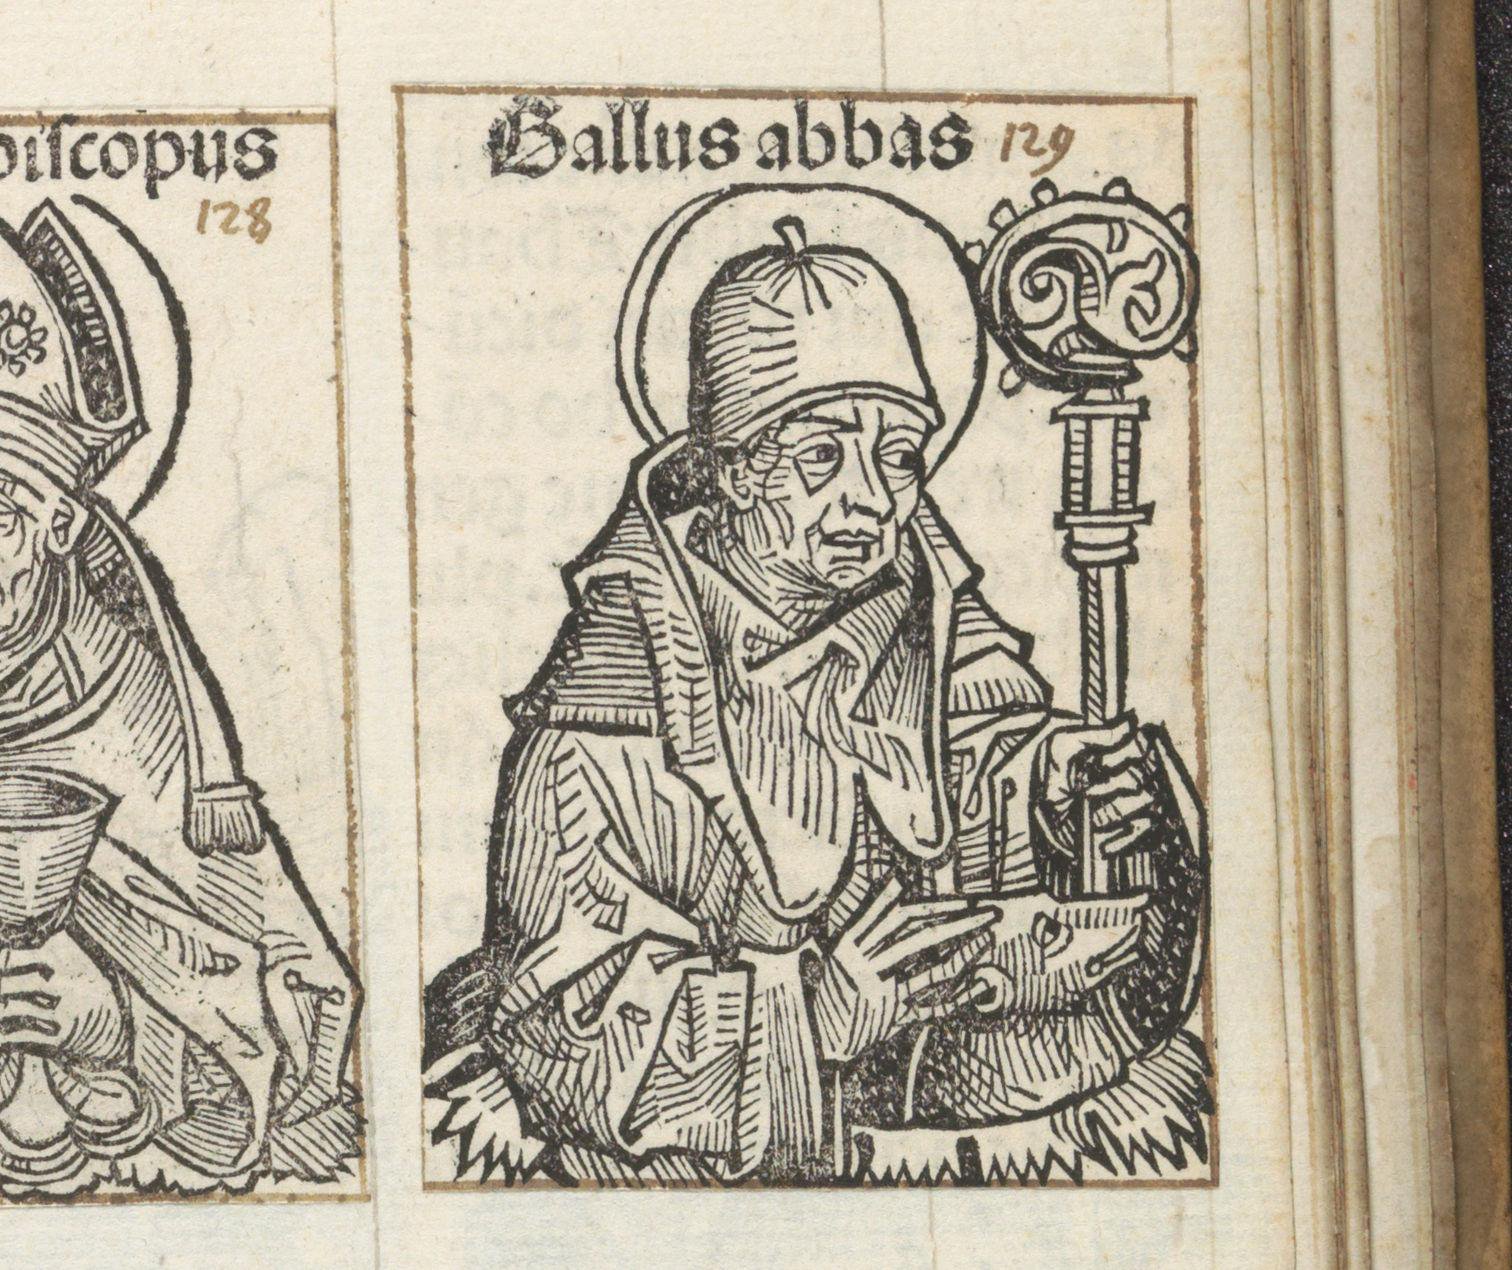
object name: album leaf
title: Liber Chronicarum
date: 1493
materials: paper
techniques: letterpress printing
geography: nuremberg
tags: archbishop, bishop, etc. (roman catholic), the monk and hermit gall(us); possible attributes: bear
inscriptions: inscription: ‘129’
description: De houtsnede wordt herhaaldelijk gebruikt als boekillustratie in de Liber Chronicarum (of Neurenbergkroniek) van Hartmann Schedel, verschenen in het Latijn en Duits in 1493. Zie de Latijnse uitgave, folio 152r.